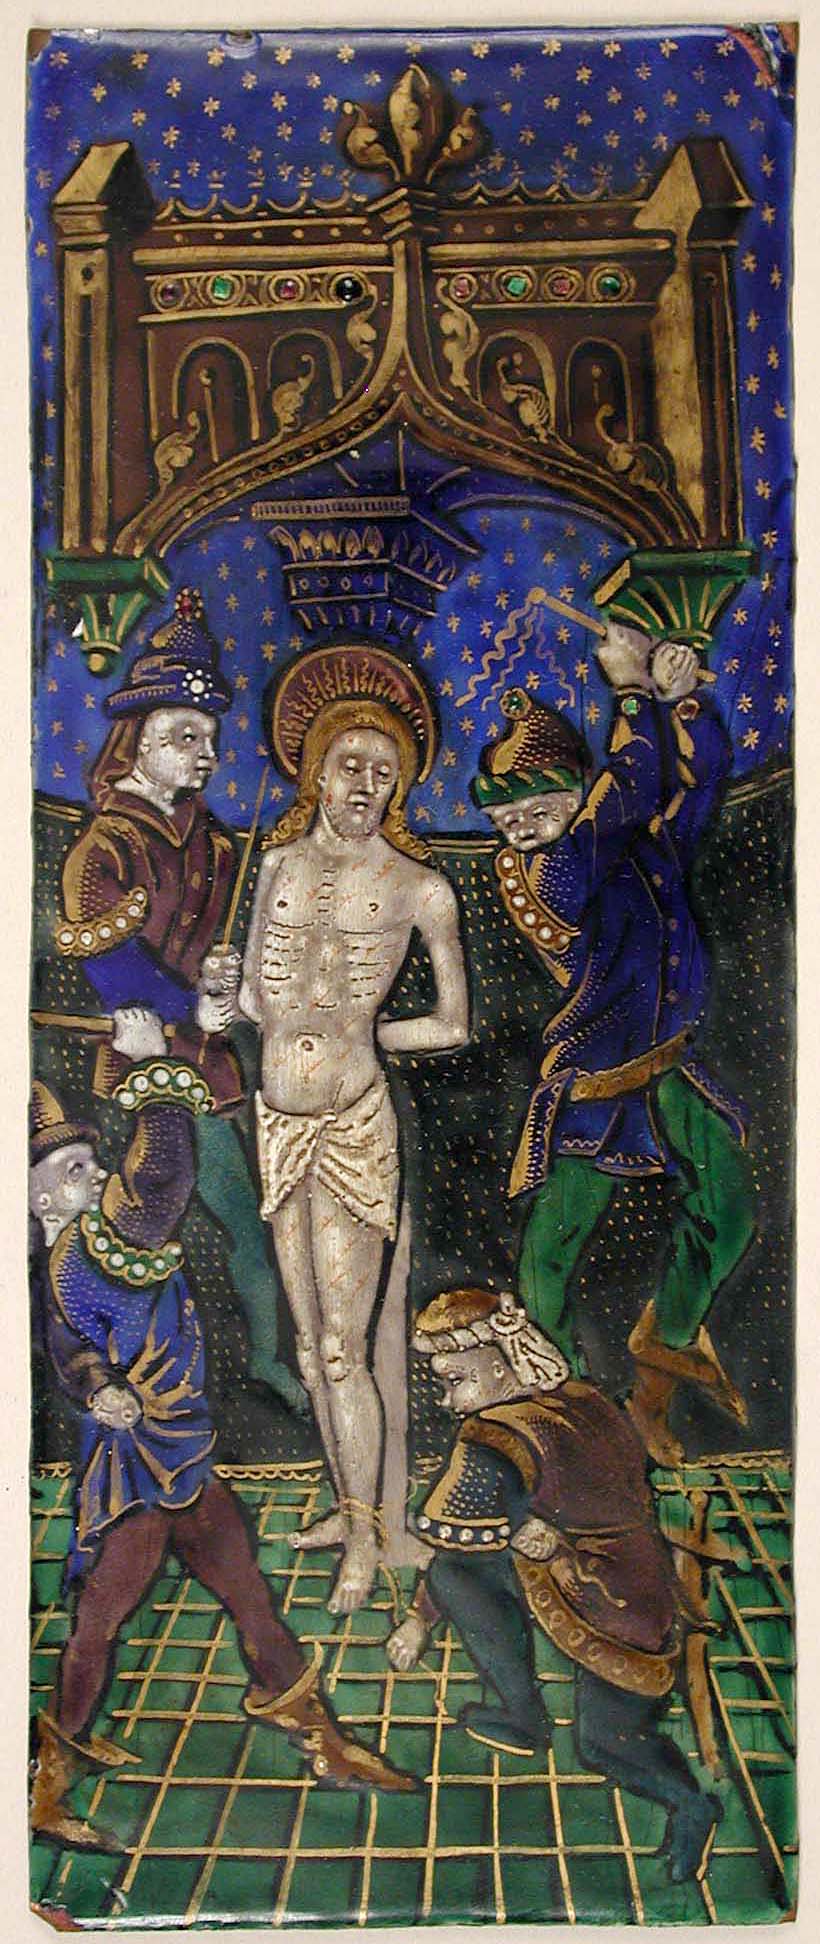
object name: triptych panel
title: Triptych Panel with the Flagellation of Christ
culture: french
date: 1501-1533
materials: copper, enamel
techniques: painting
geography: france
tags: men,crucifixion,punishment